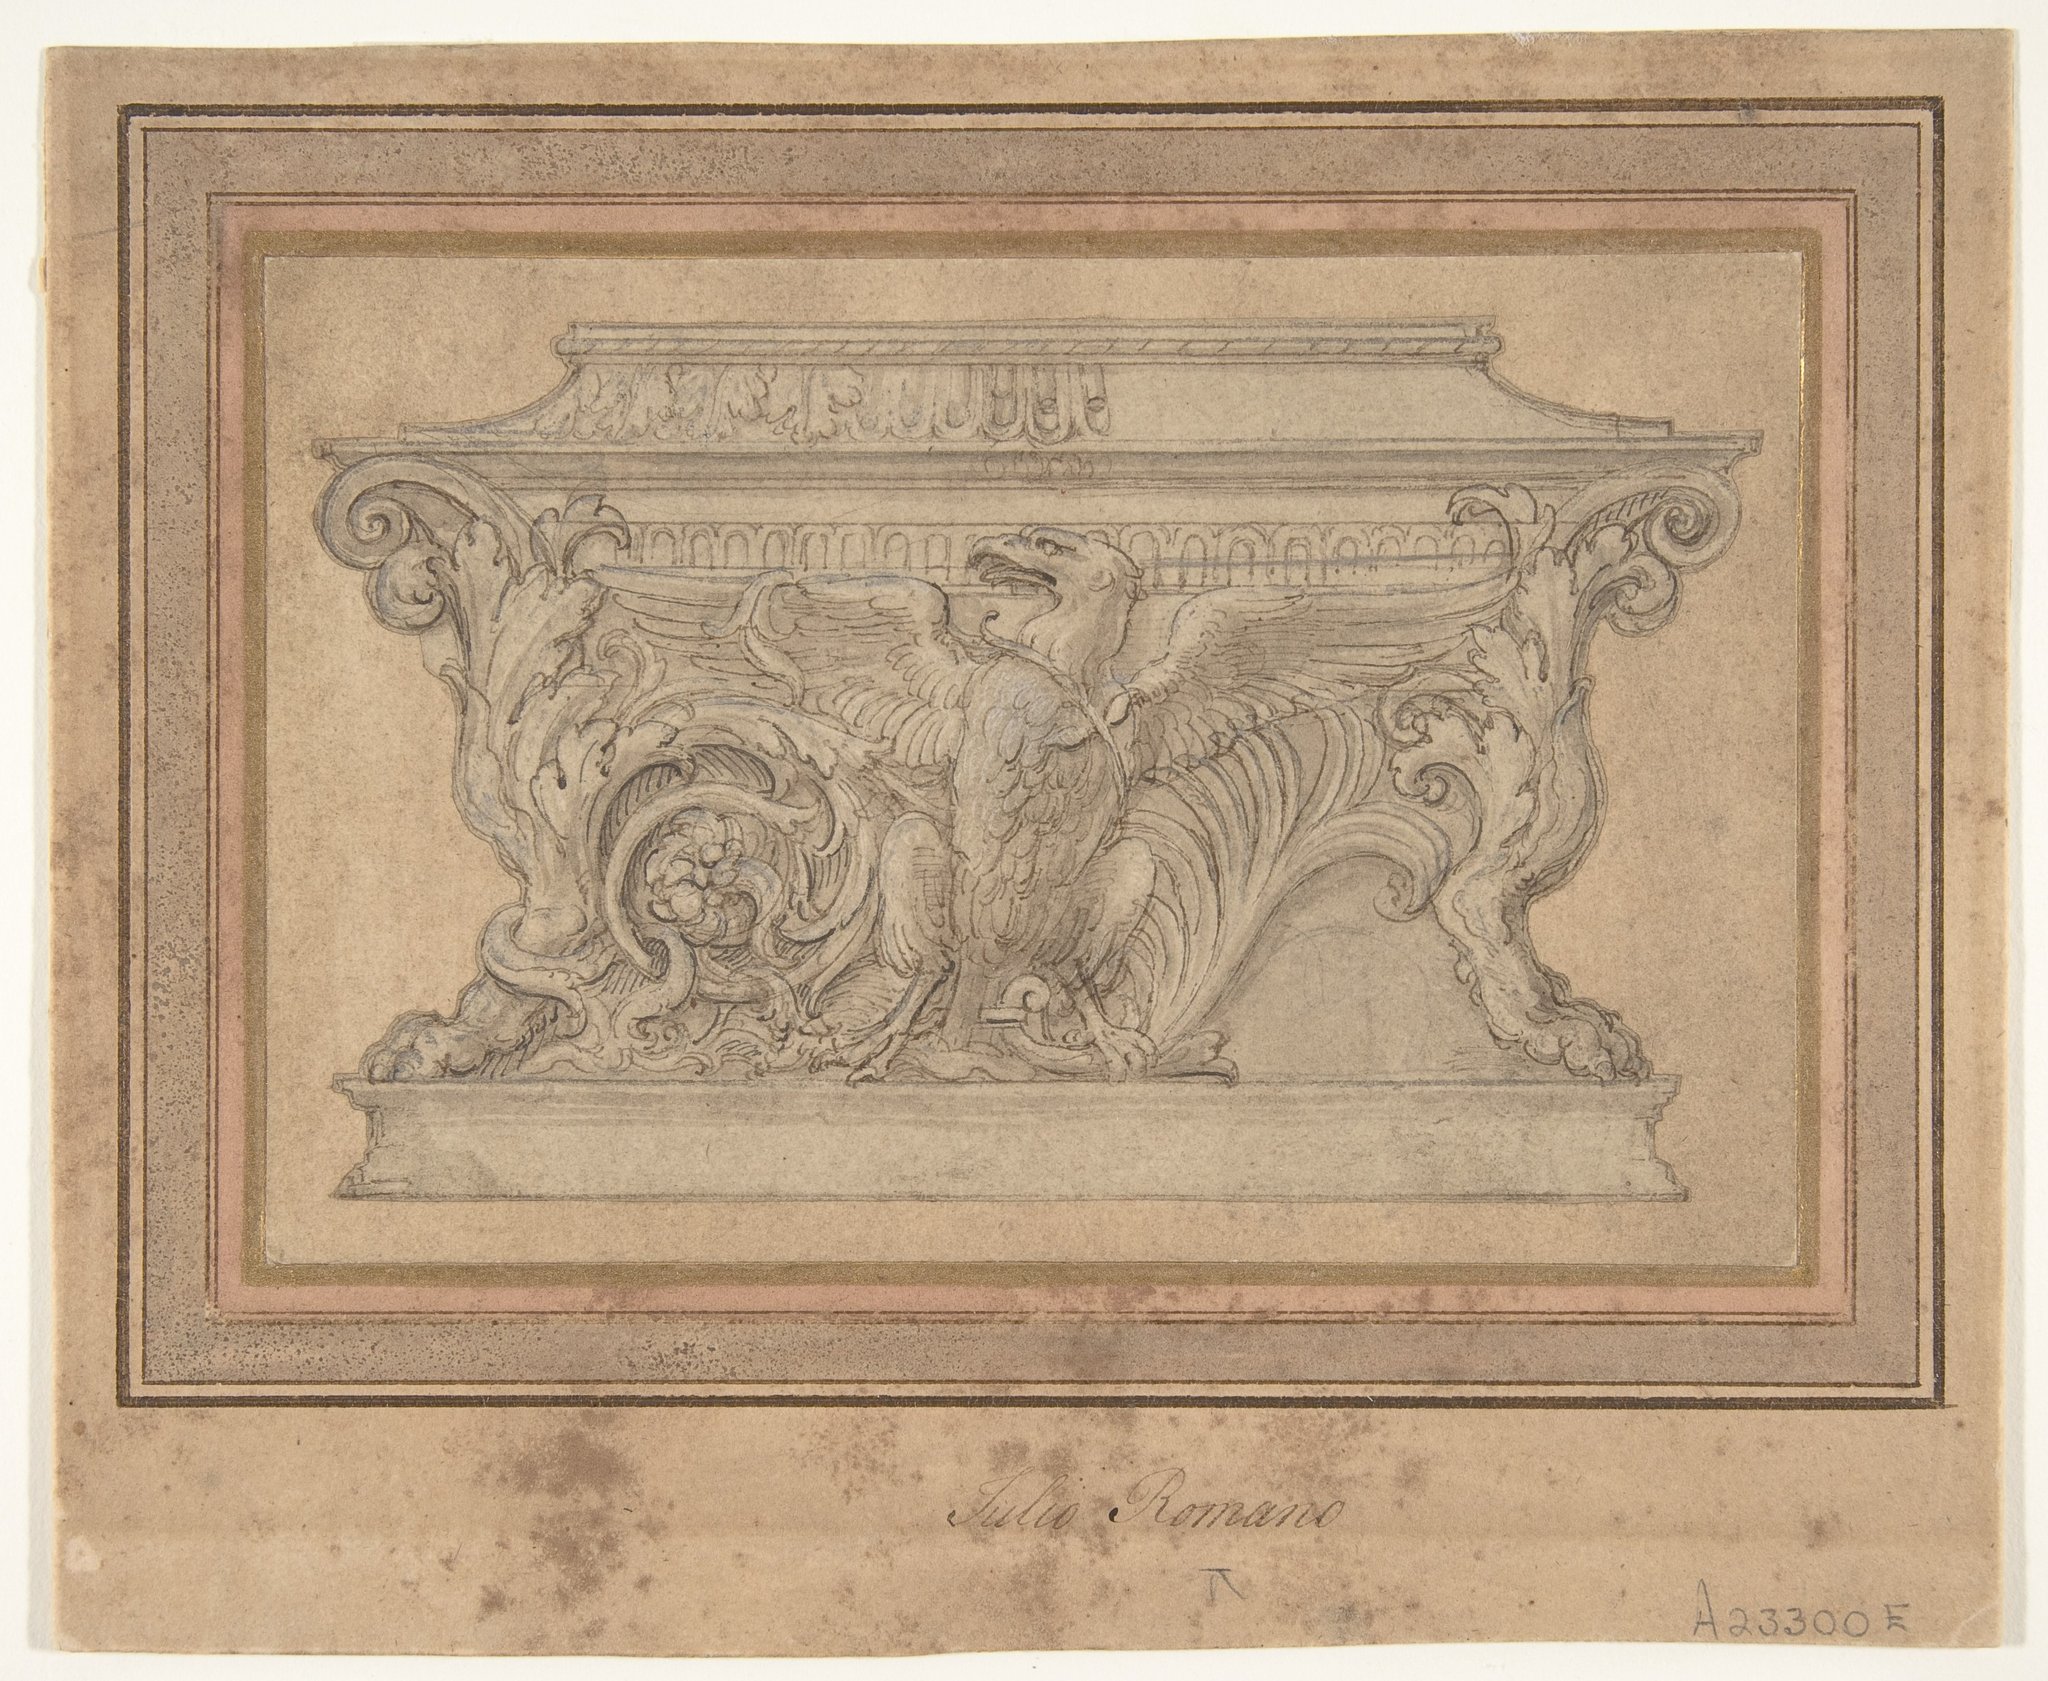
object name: drawing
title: Design for a Casket with the Gonzaga Eagle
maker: giulio romano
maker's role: artist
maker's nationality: italian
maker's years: 1499-1546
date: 1527-1546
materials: chalk, gouache, ink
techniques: brush, highlighting, pen, wash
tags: eagles